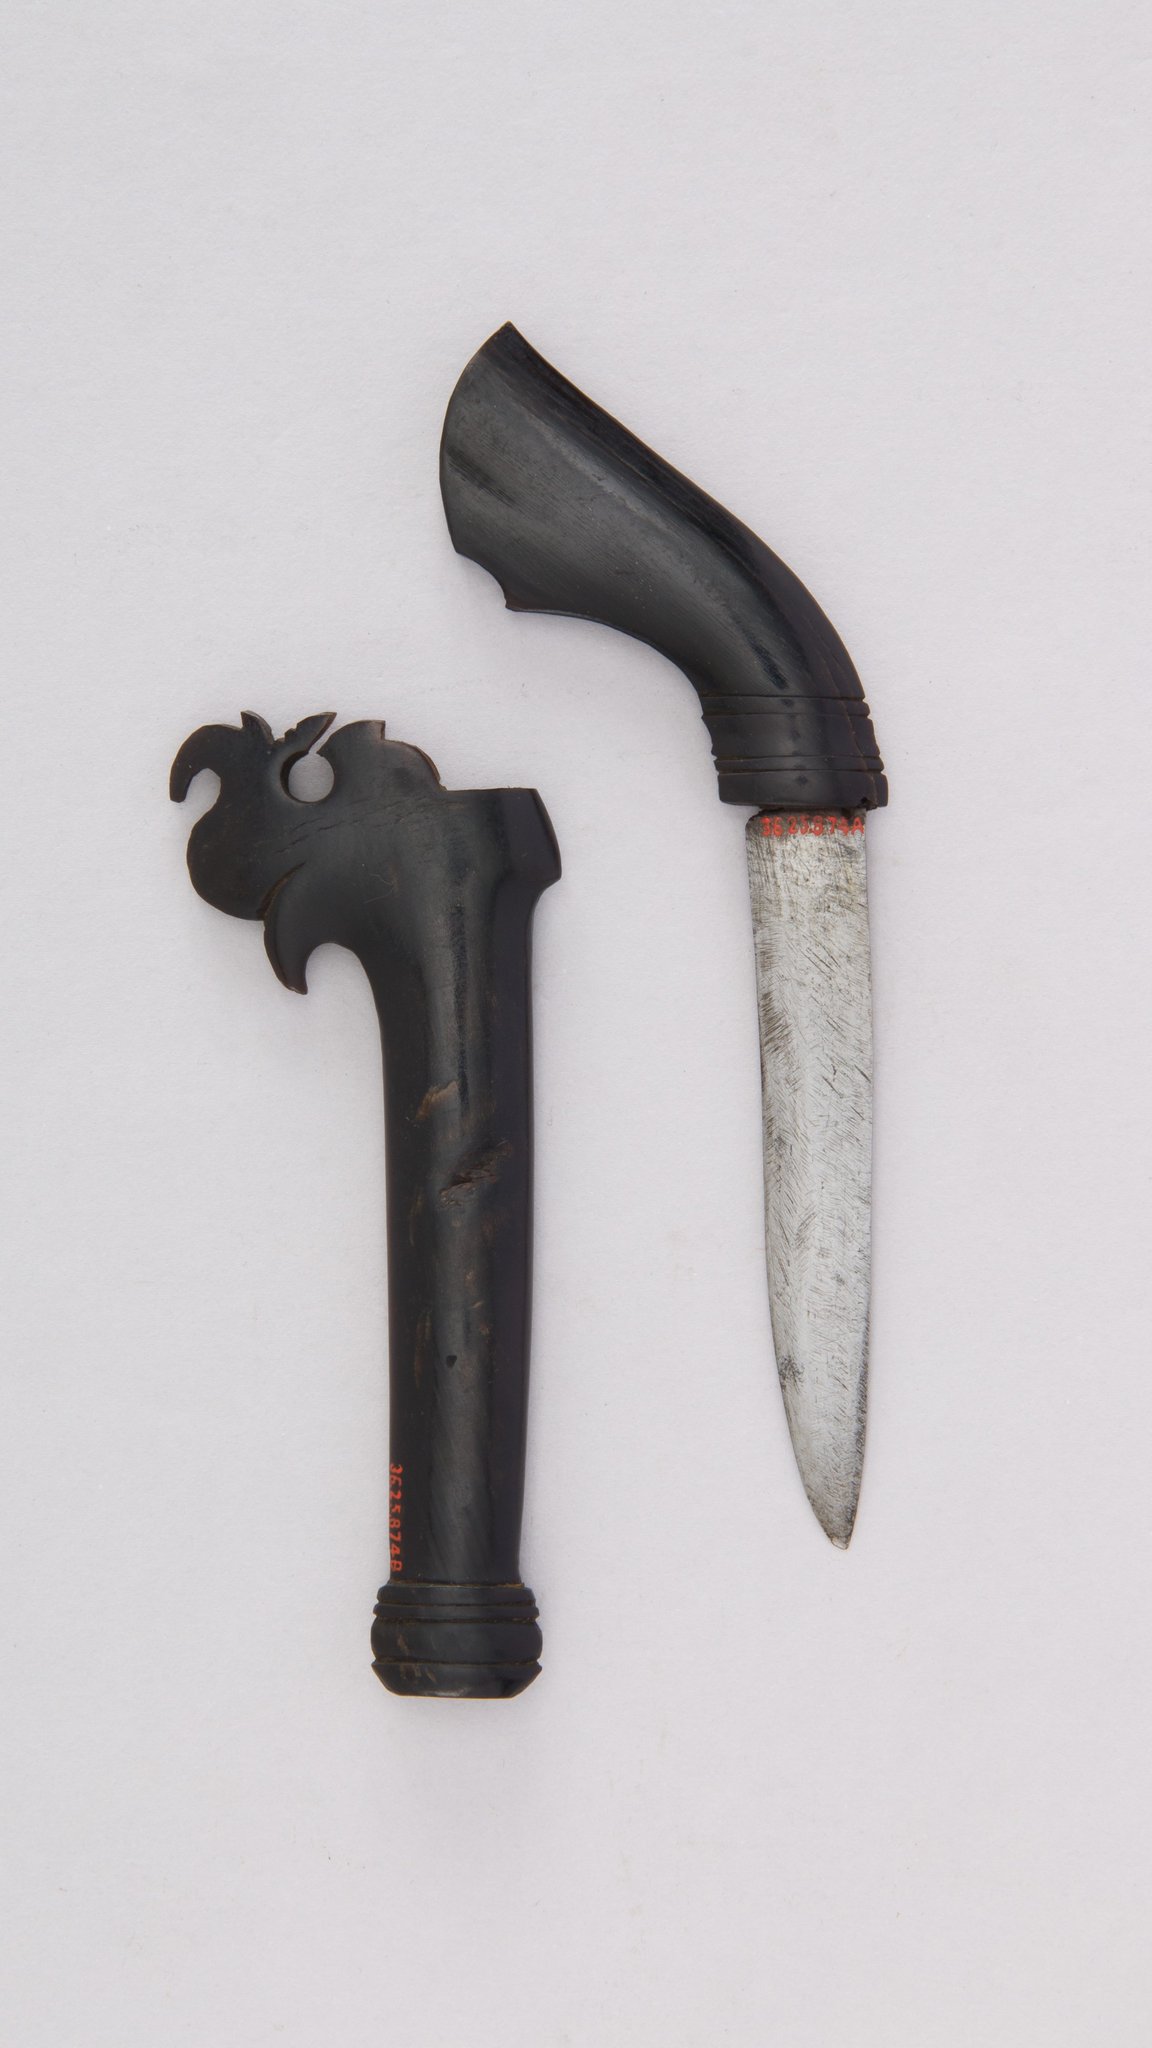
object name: knife with sheath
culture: indonesian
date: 1701-1900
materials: horn, steel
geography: sulawesi